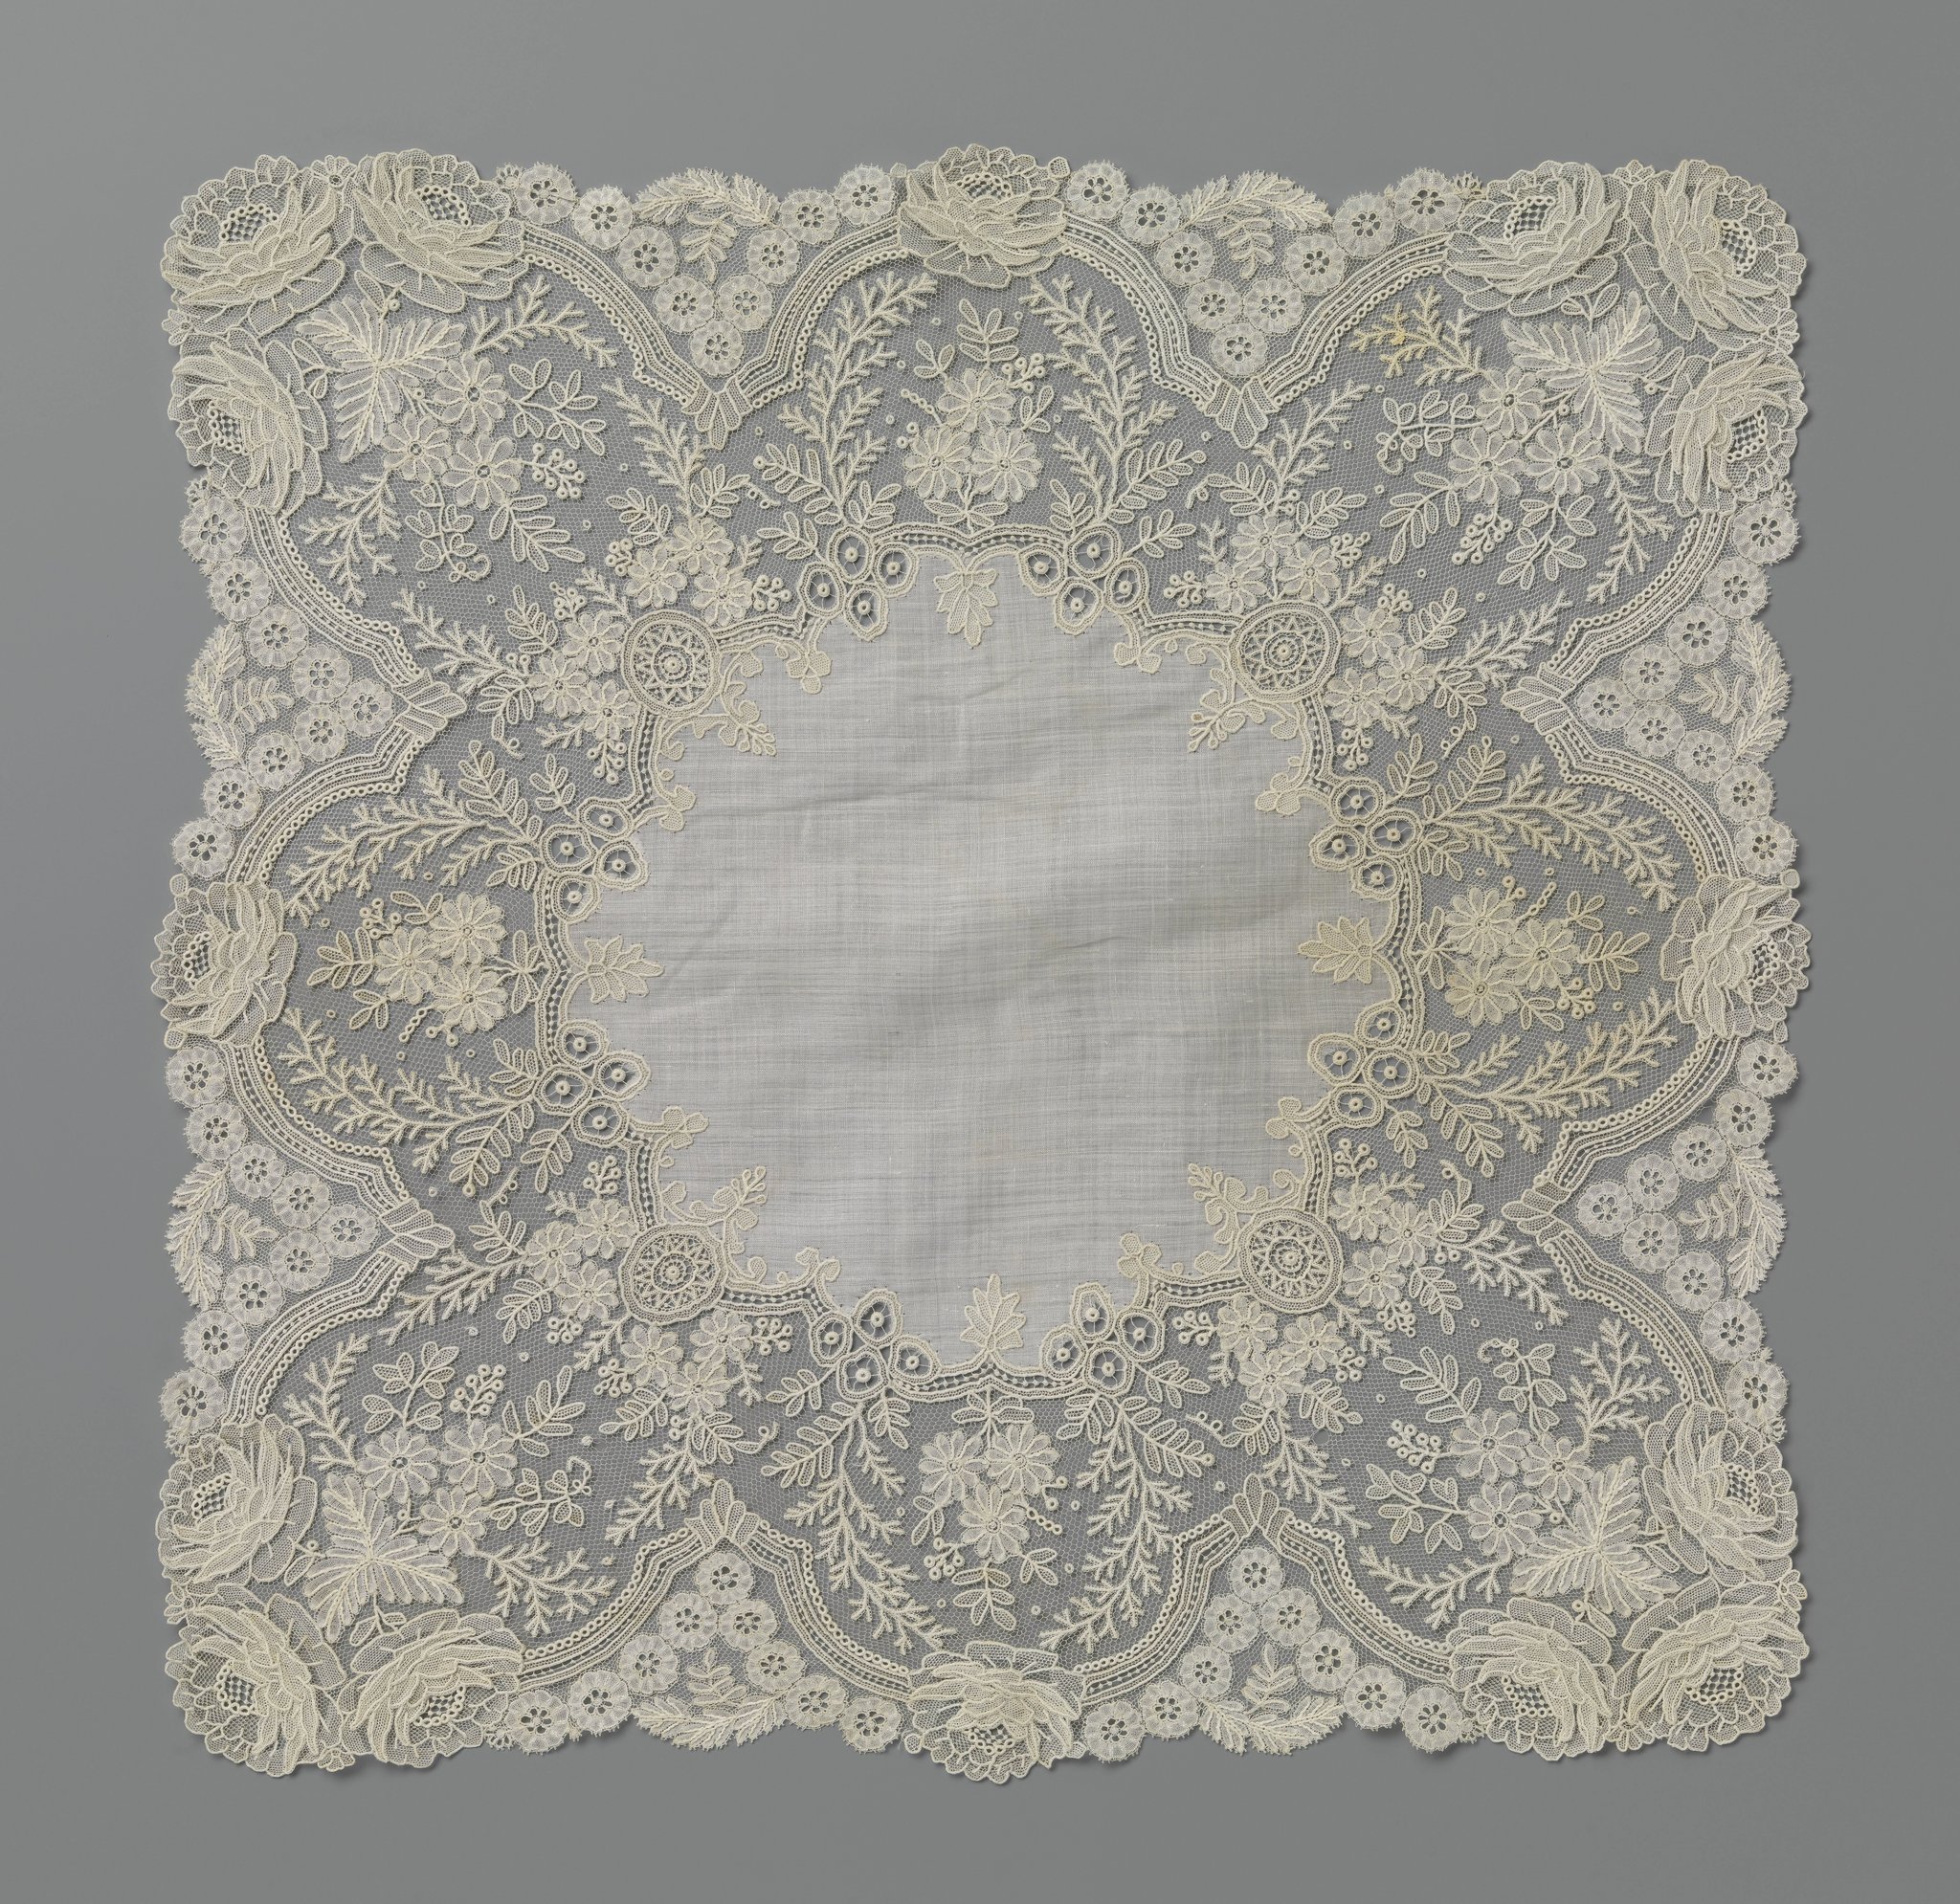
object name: handkerchief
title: Zakdoek met een rand van gemengde kant met spoorrails en parelsnoertje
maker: Anonymous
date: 1880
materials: linen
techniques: lace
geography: brussels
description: Zakdoek met een rand van naturelkleurige gemengde kant: Brusselse kloskant in combinatie met naaldkant en met een naaldkantgrond, een fijne gaaskantgrond. Dit type kant wordt ook wel point d'Angleterre genoemd. Een rond batisten middenstukje is afgezet met een kanten rand met acht diepe schulpen, gevormd door 'spoorrails', een parelsnoertje en een keten van madeliefjes. In de schulpen staan toefjes van een drietal madeliefjes tussen fijne wilgentakjes. De bogen der schulpen worden in het midden oversneden door een grote reliëfroos, in de hoeken door drie rozen.